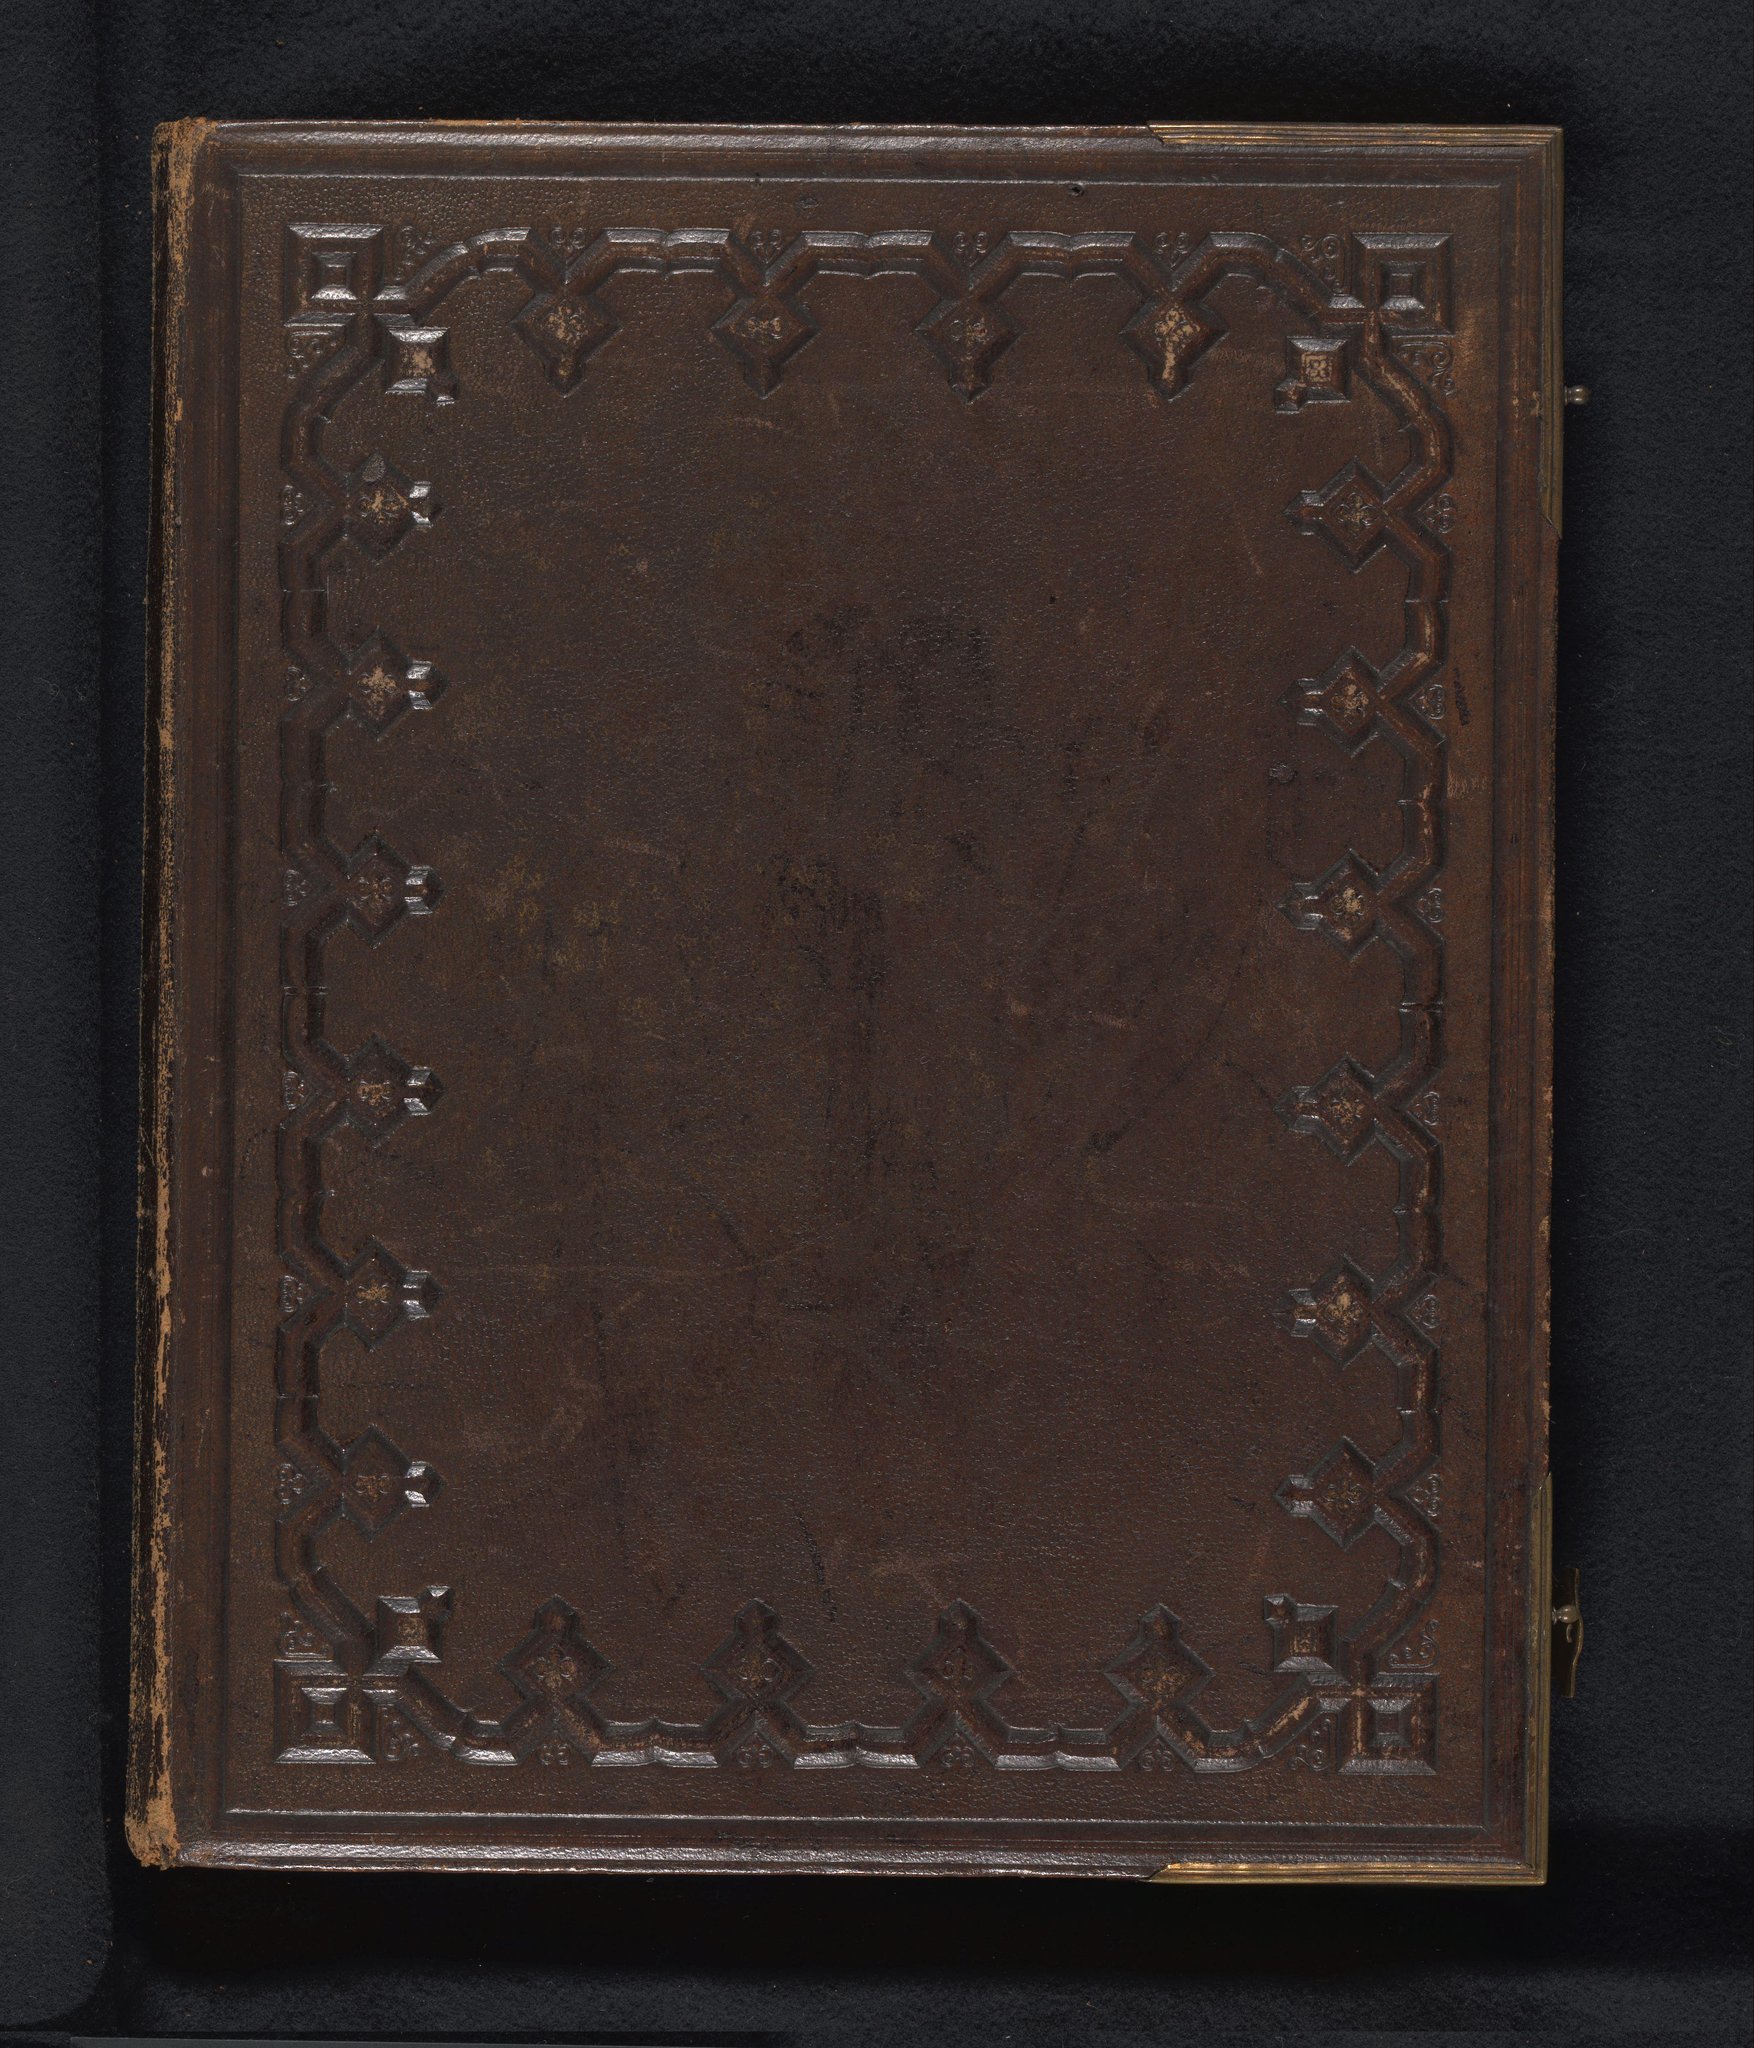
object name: photograph album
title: Fotoalbum met 96 foto's van leden van Europese koninklijk huizen en van bekende Nederlandse en Duitse personen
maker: Anonymous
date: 1850-1900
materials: cardboard, copper, leather, paper, photographic support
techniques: albumen print, printing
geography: netherlands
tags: brussels, willem iii (koning der nederlanden), paris, victor hugo, the hague, sophia frederika mathilda van württemberg, historical persons - bb - woman, historical persons, queen, king, family of the sovereign, europe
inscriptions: collector's mark: ‘DIENST/ VERSPREIDE/ RIJKSKOLLEKTIES/ (...) A677’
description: Fotoalbum met 24 pagina's met in totaal 96 cartes-de-visite in passe-partouts. Iedere pagina bevat vier met gouden lijnen omkaderde rechthoekige passe-partouts. Onder het merendeel van de passe-partouts is met de hand de naam en het geboorte- en sterfjaar van de geportretteerde geschreven. Afgebeeld zijn leden van de koninklijk huizen van Europa uit de 19e eeuw, zoals koning Willem III, Maria van Oranje-Nassau en koningin Sophia, alsmede Duitse en Nederlandse schrijvers, theologen, wetenschappers en politici, zoals Victor Hugo, Otto Eduard von Bismarck en Abraham Lincoln. De foto's zijn gemaakt door verschillende fotografen, waaronder Maurits Verveer, L. Haase und Comp., Disdéri, Ludwig Angerer en Charles Reutlinger.